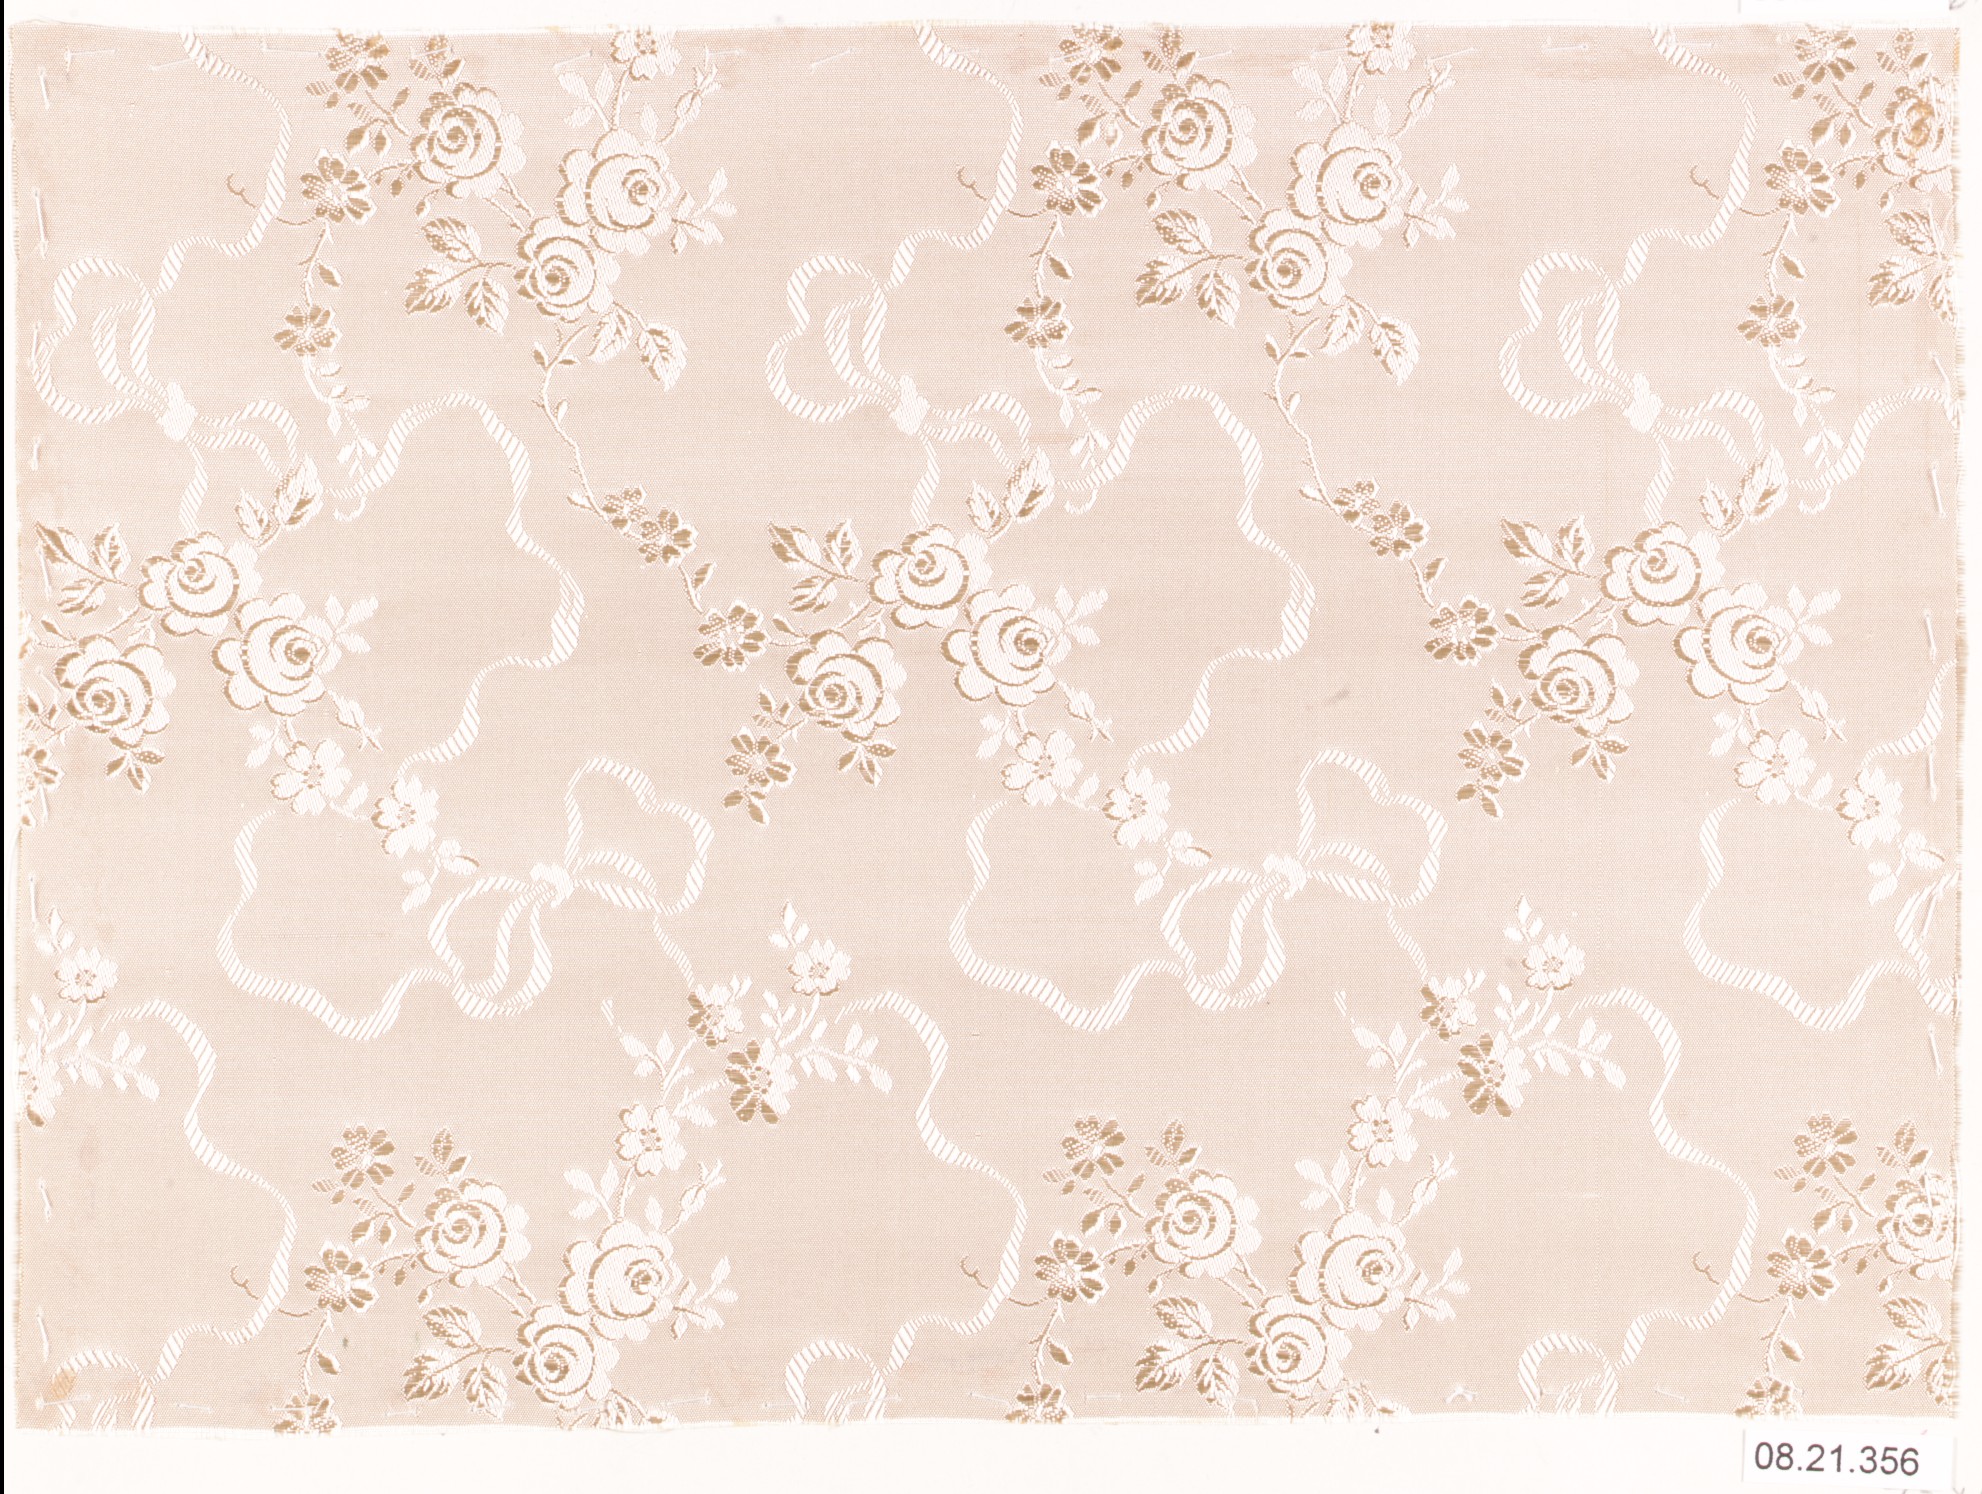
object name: textile sample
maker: Anonymous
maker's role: designer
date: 1900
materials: silk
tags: roses